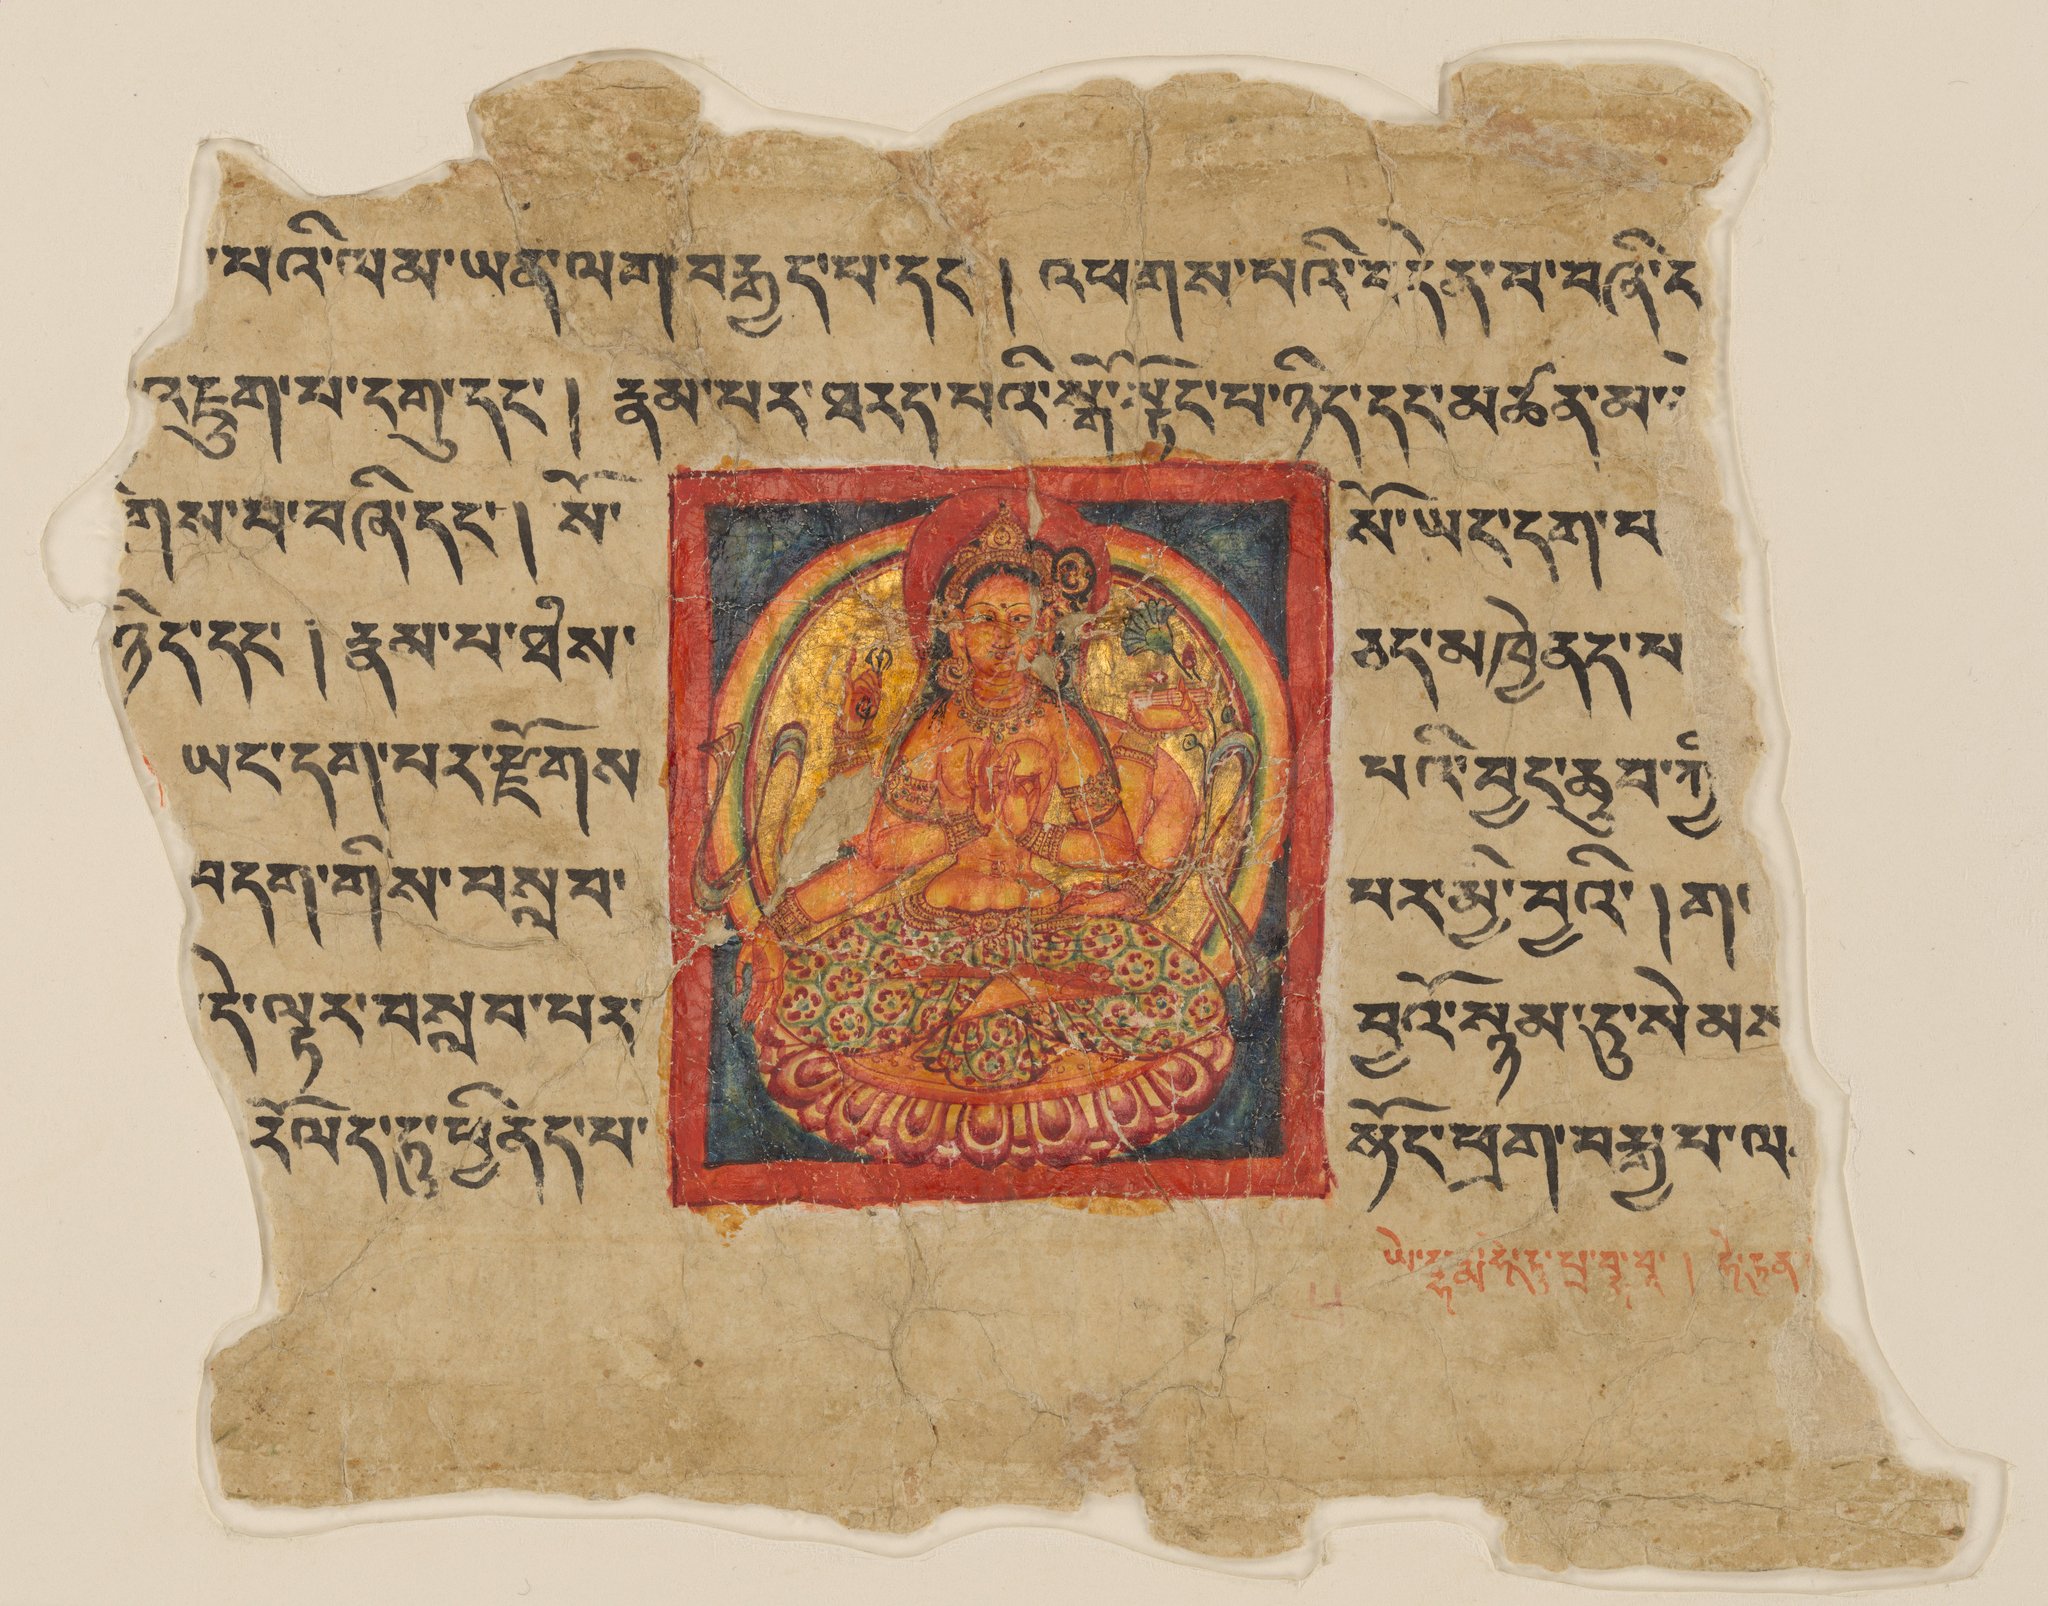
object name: folio fragment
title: Fragmentary Leaf from an Ashtasahasrika Prajnaparamita Sutra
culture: kashmiri or western tibetan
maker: unidentified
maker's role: artist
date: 1101-1200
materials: gold, ink, lapis lazuli, paper, pigment